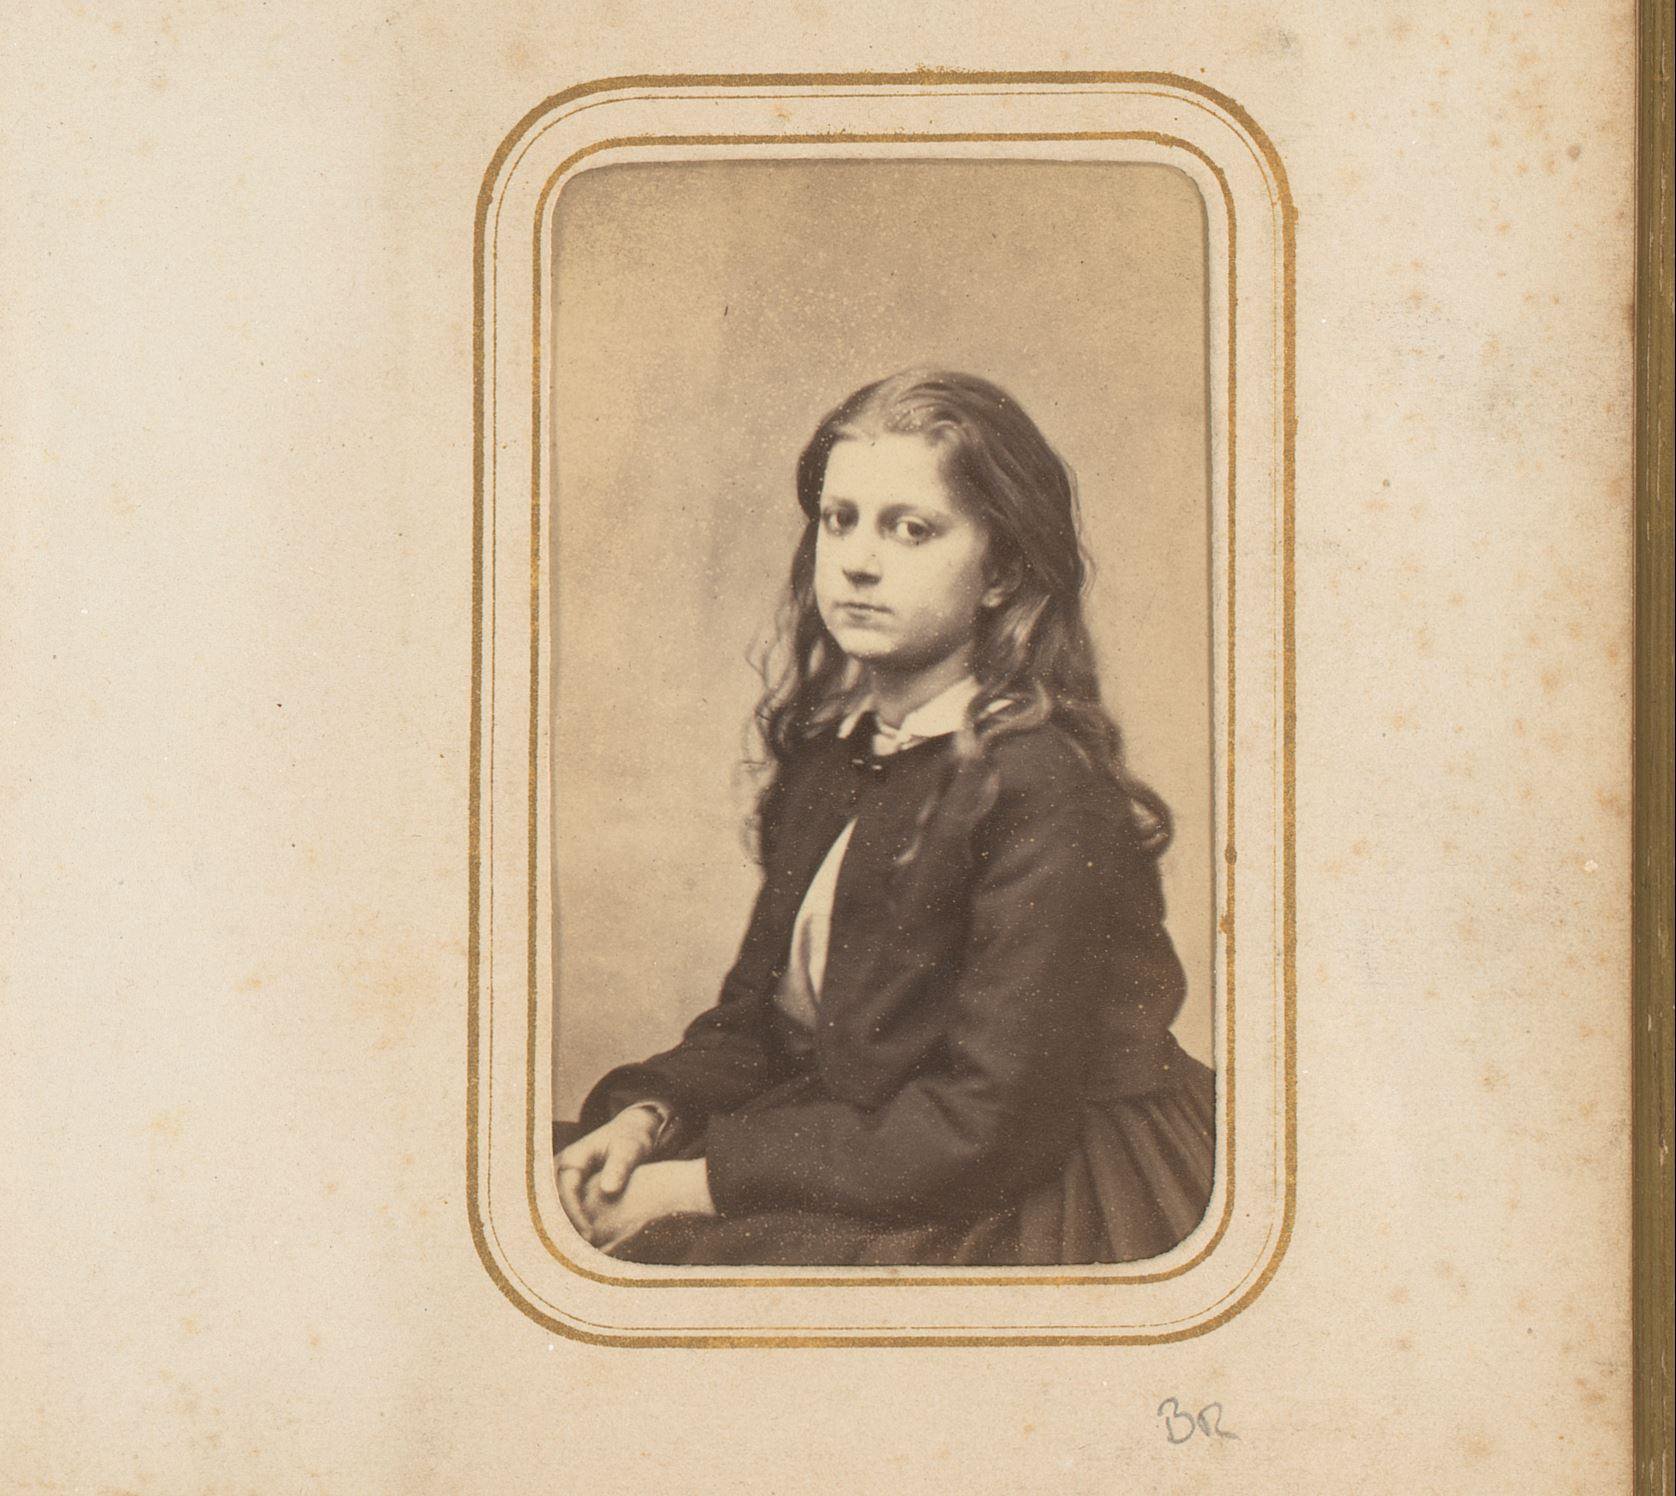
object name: album leaf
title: Portret van een meisje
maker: Anonymous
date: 1860-1880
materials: cardboard, photographic support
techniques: albumen print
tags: girl (child between toddler and youth)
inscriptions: inscription: ‘[...] Palais Royal 65’, annotation: ‘Souvenir d'amitié de magdeleine Del Jartey a celle que j'aime de tout mon coeury/ M. Del Jartey’